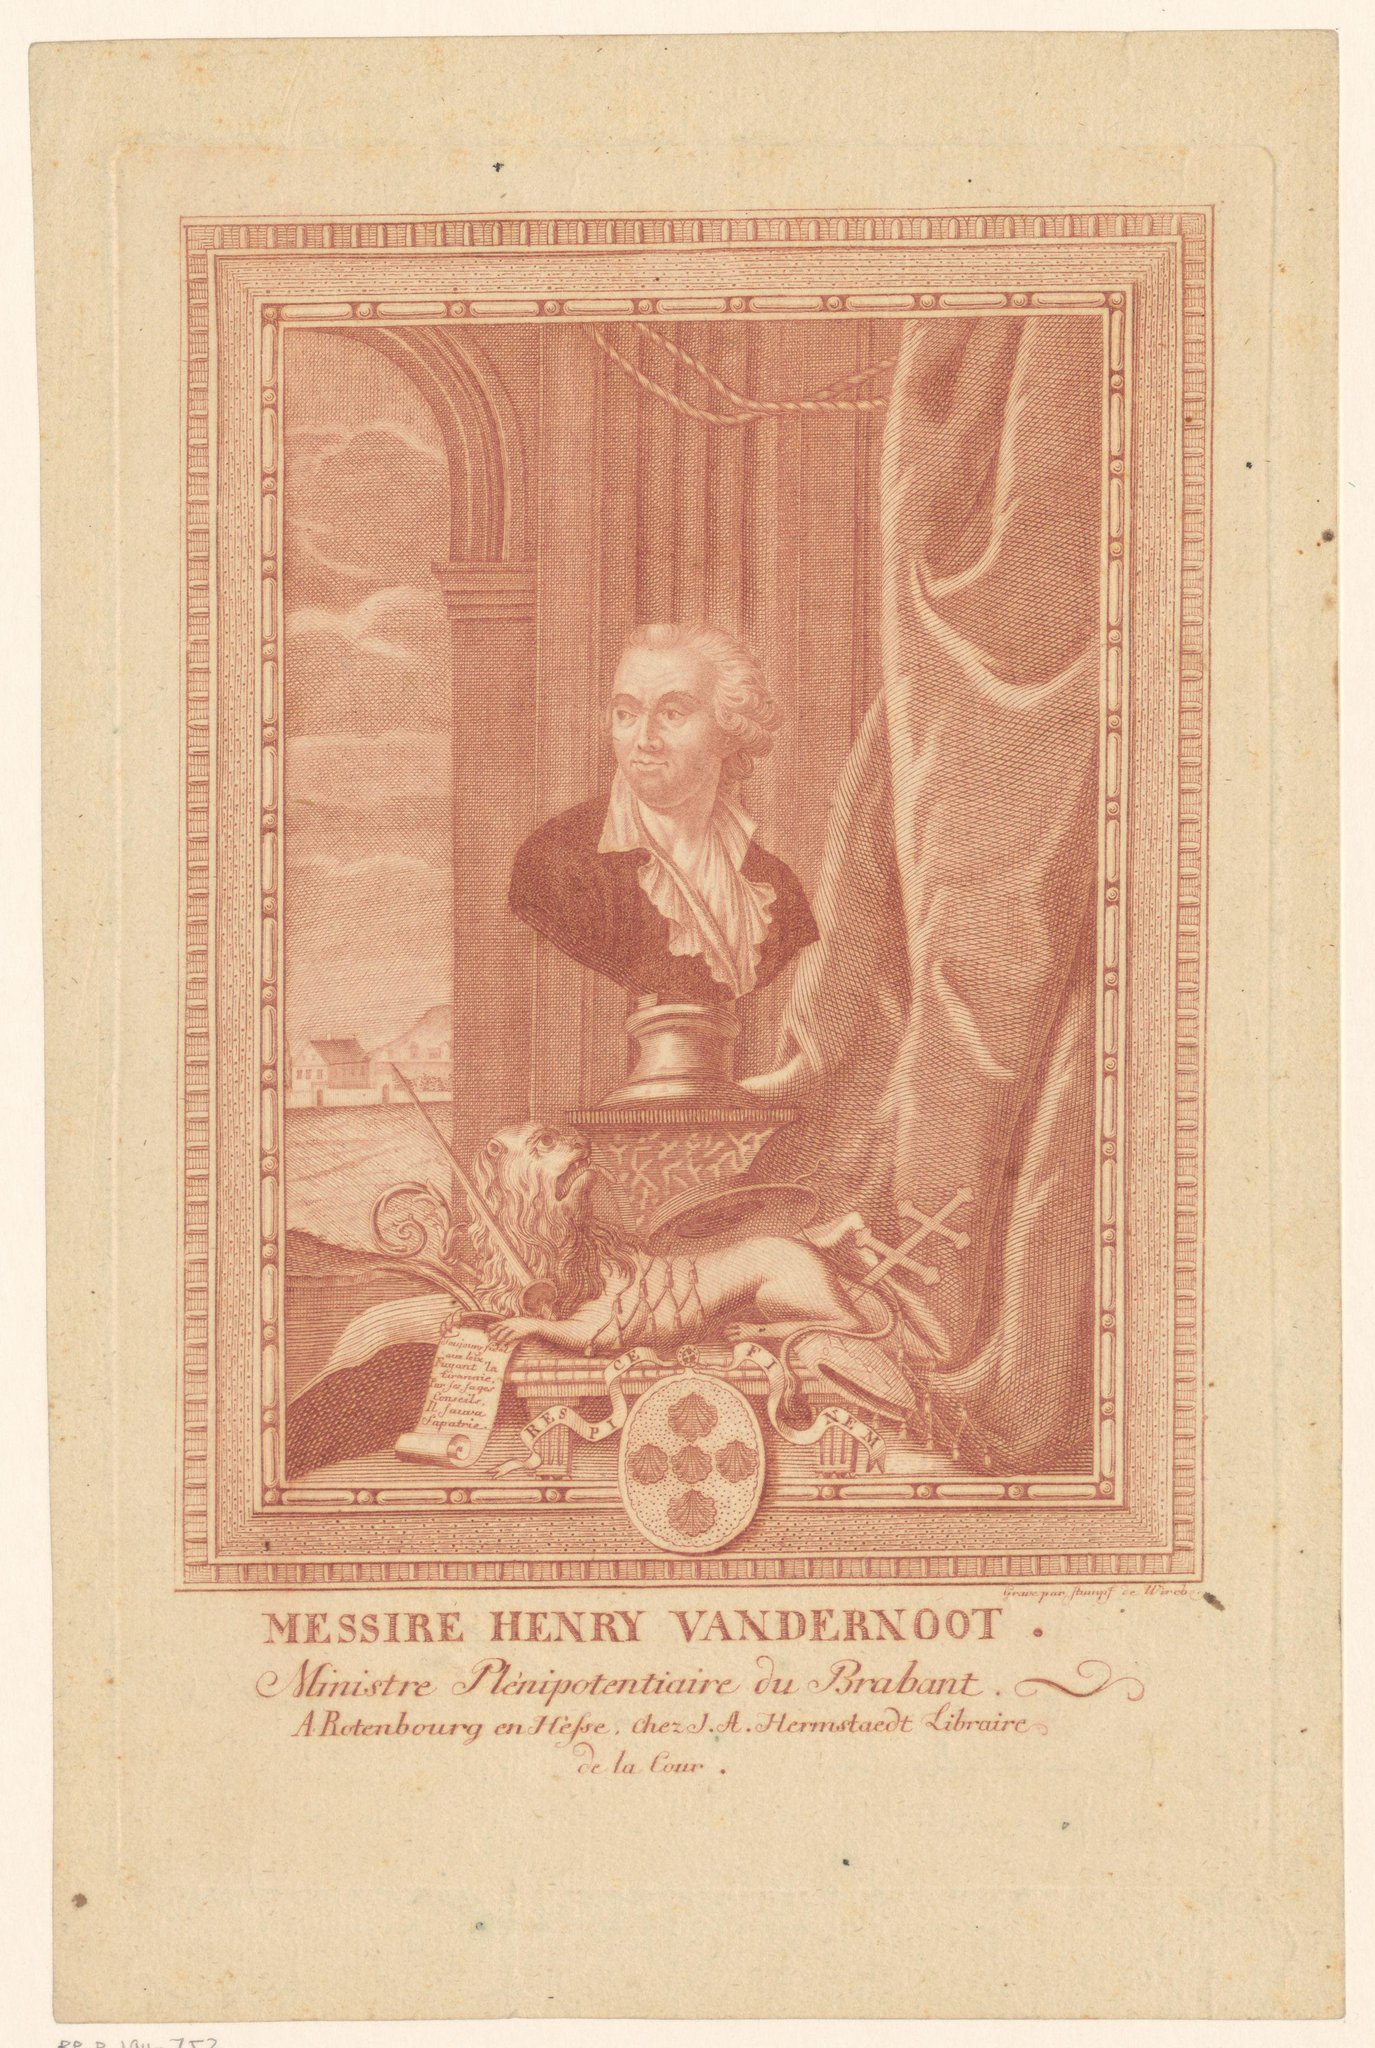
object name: print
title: Portret van Hendrik Karel Nicolaas van der Noot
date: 1764-1809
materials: paper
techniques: etching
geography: rotenburg an der fulda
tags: brussels, politician, historical persons, piece of sculpture, reproduction of a piece of sculpture, armorial bearing, heraldry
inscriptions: collector's mark: Lugt 2228